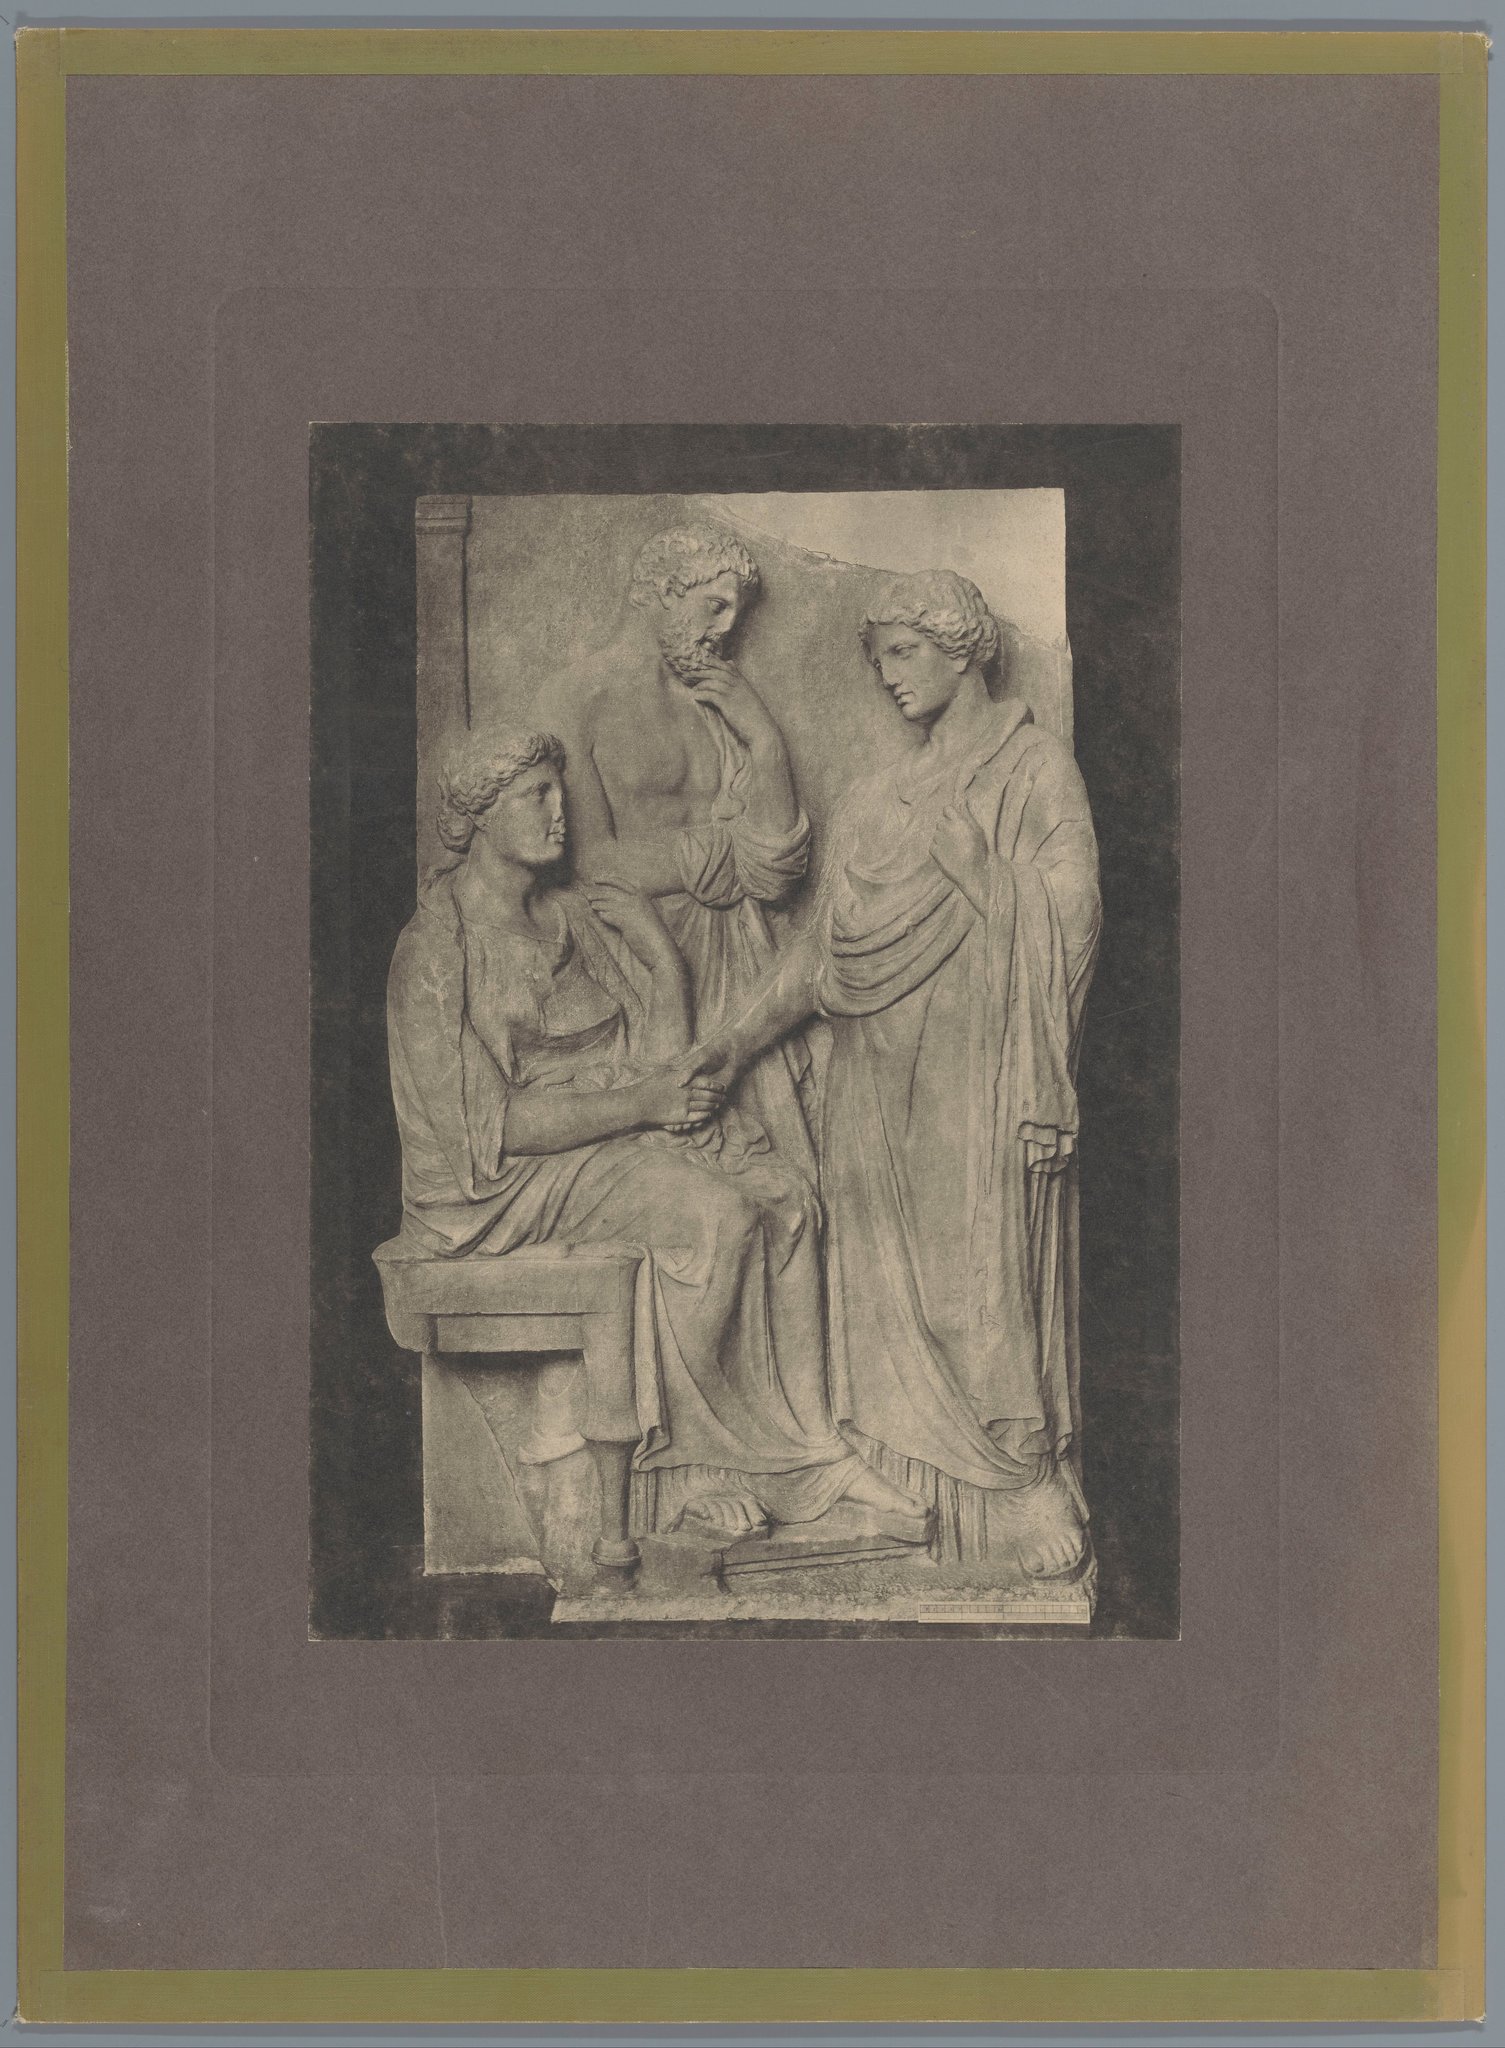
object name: photograph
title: Grafreliëf afkomstig uit Athene met een zittend en twee staande personen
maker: Anonymous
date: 1898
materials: cardboard, paper, ink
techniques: photograph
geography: europe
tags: gravestone, tombstone, sculpture (+ relief ~ sculpture)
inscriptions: collector's mark: Lugt 3937, number: ‘No. 47.’, inscription: